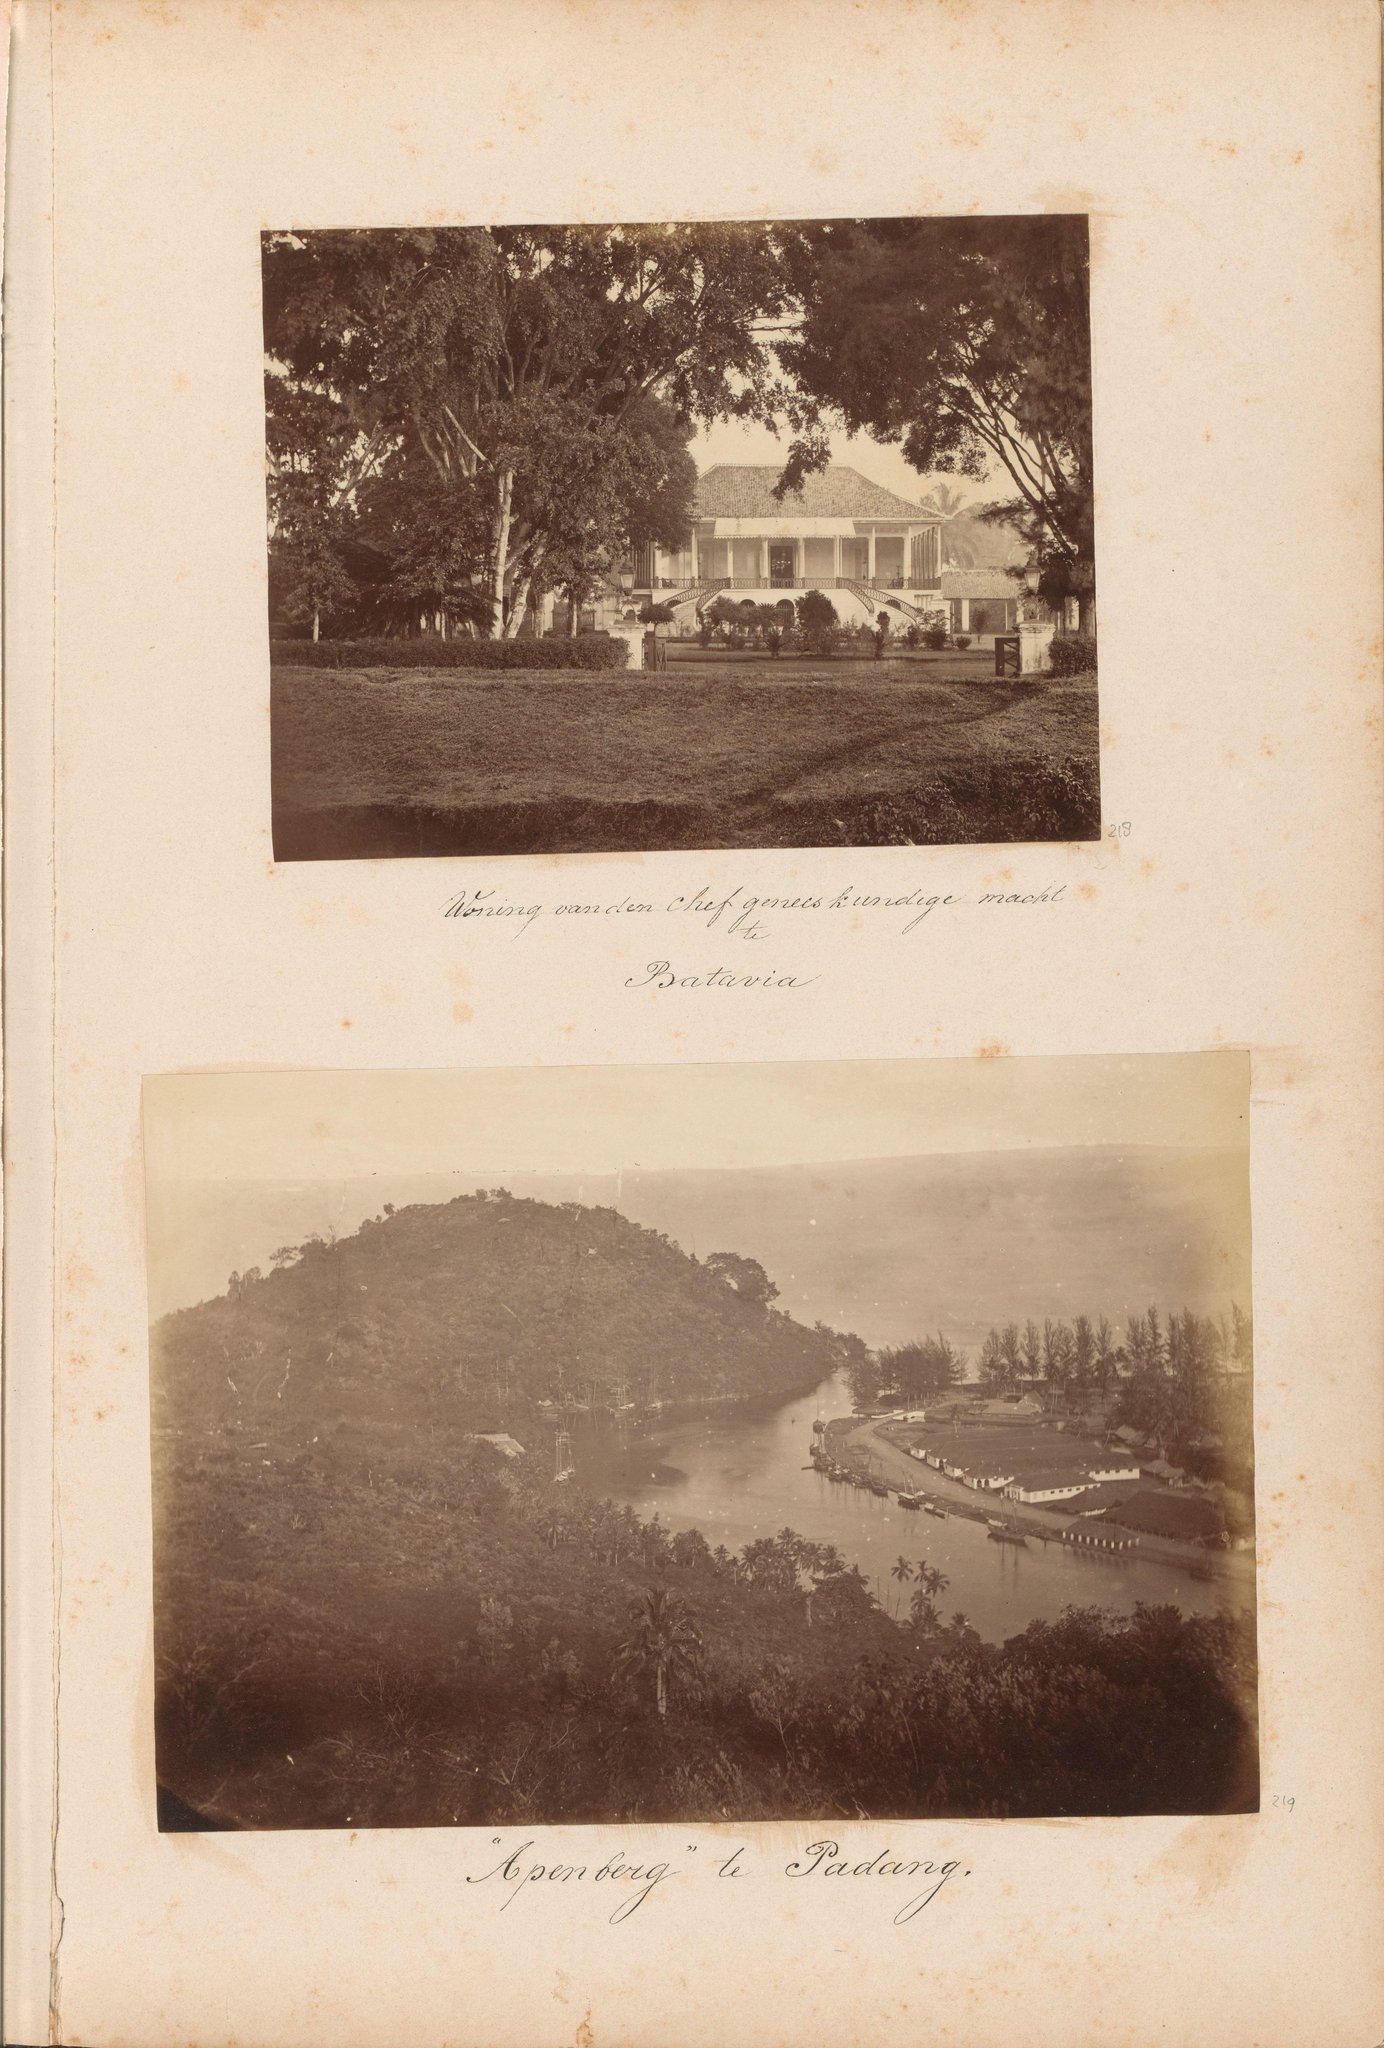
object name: album leaf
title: Gezicht op de woning en tuinen van de chef geneeskundige macht in Batavia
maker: Anonymous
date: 1870-1880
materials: paper, photographic support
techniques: albumen print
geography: batavia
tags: garden, rural housing, e.g. country-house, villa, cottage, batavia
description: Onderdeel van Fotoalbum van Robert Daniel Crommelin (1841-1907).